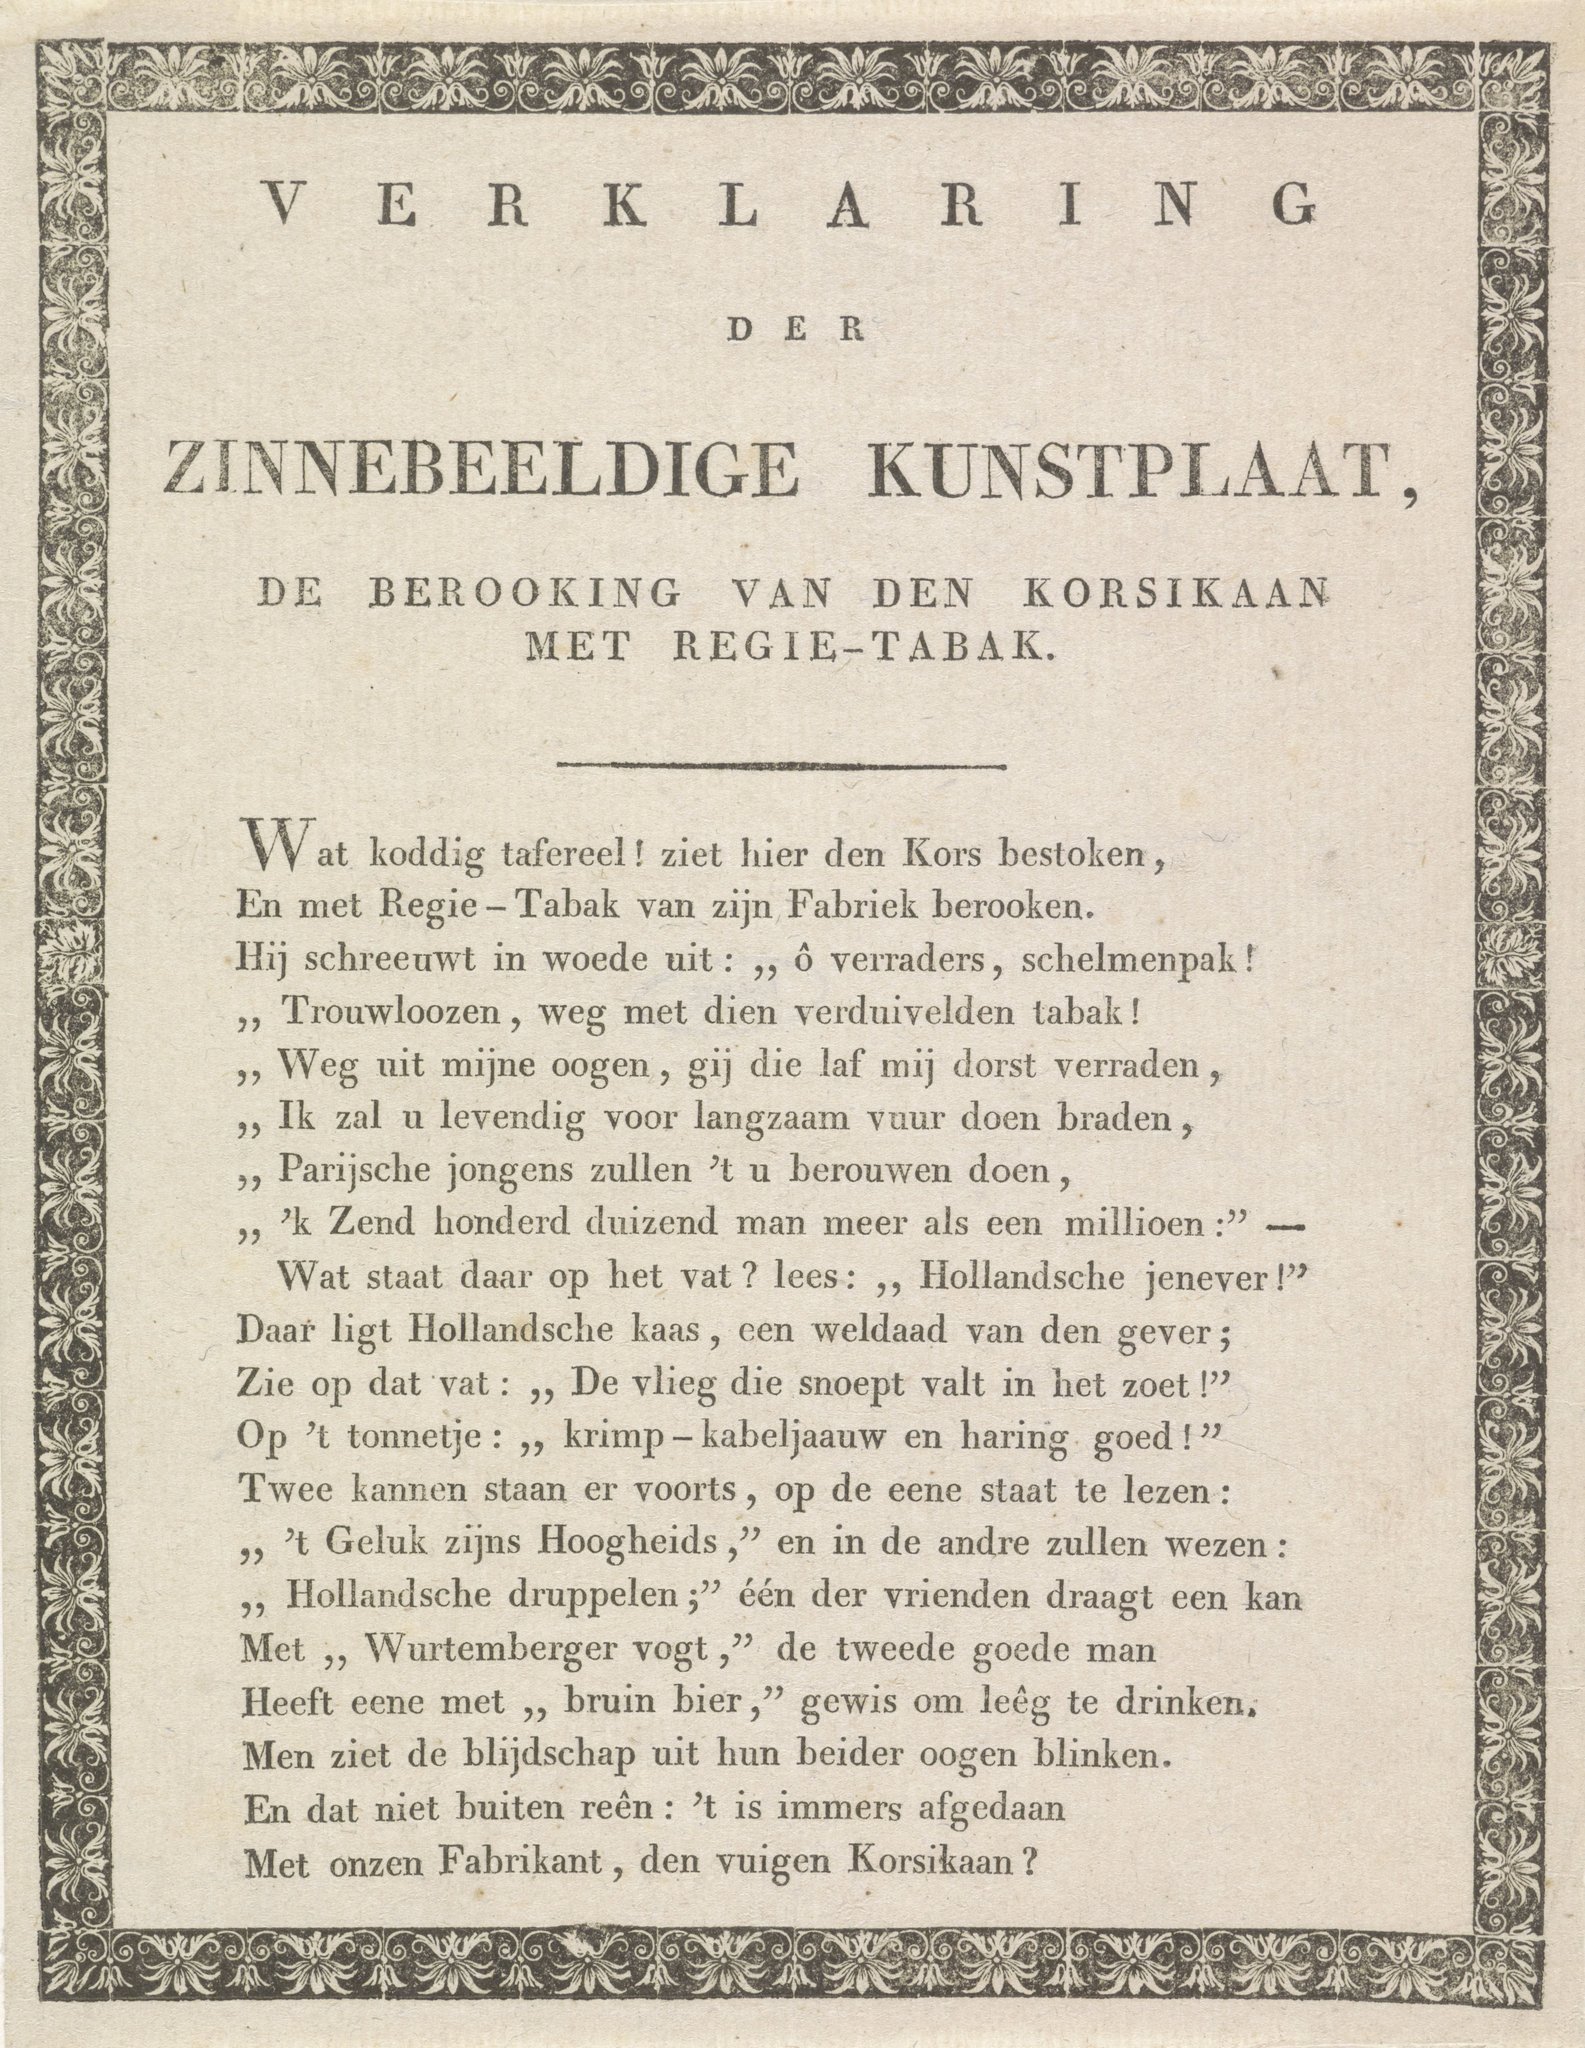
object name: text sheet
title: Verklaring der Zinnebeeldige Kunstplaat, de berooking van den Korsikaan mer regie-tabak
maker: Anonymous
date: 1813-1815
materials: paper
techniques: letterpress printing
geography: netherlands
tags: napoleon i (emperor of the french), smoke, pipe ~ tobacco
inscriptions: collector's mark: Lugt 2228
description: Gedrukte verklaring van de spotprent met Napoleon stampvoetend bovenop een grote houten vat met Hollandse jenever terwijl de vertegenwoordigers van verschillende Europese landen allen pijproken en tabaksrook naar de keizer blazen. Vers van twintig regels binnen een kader.